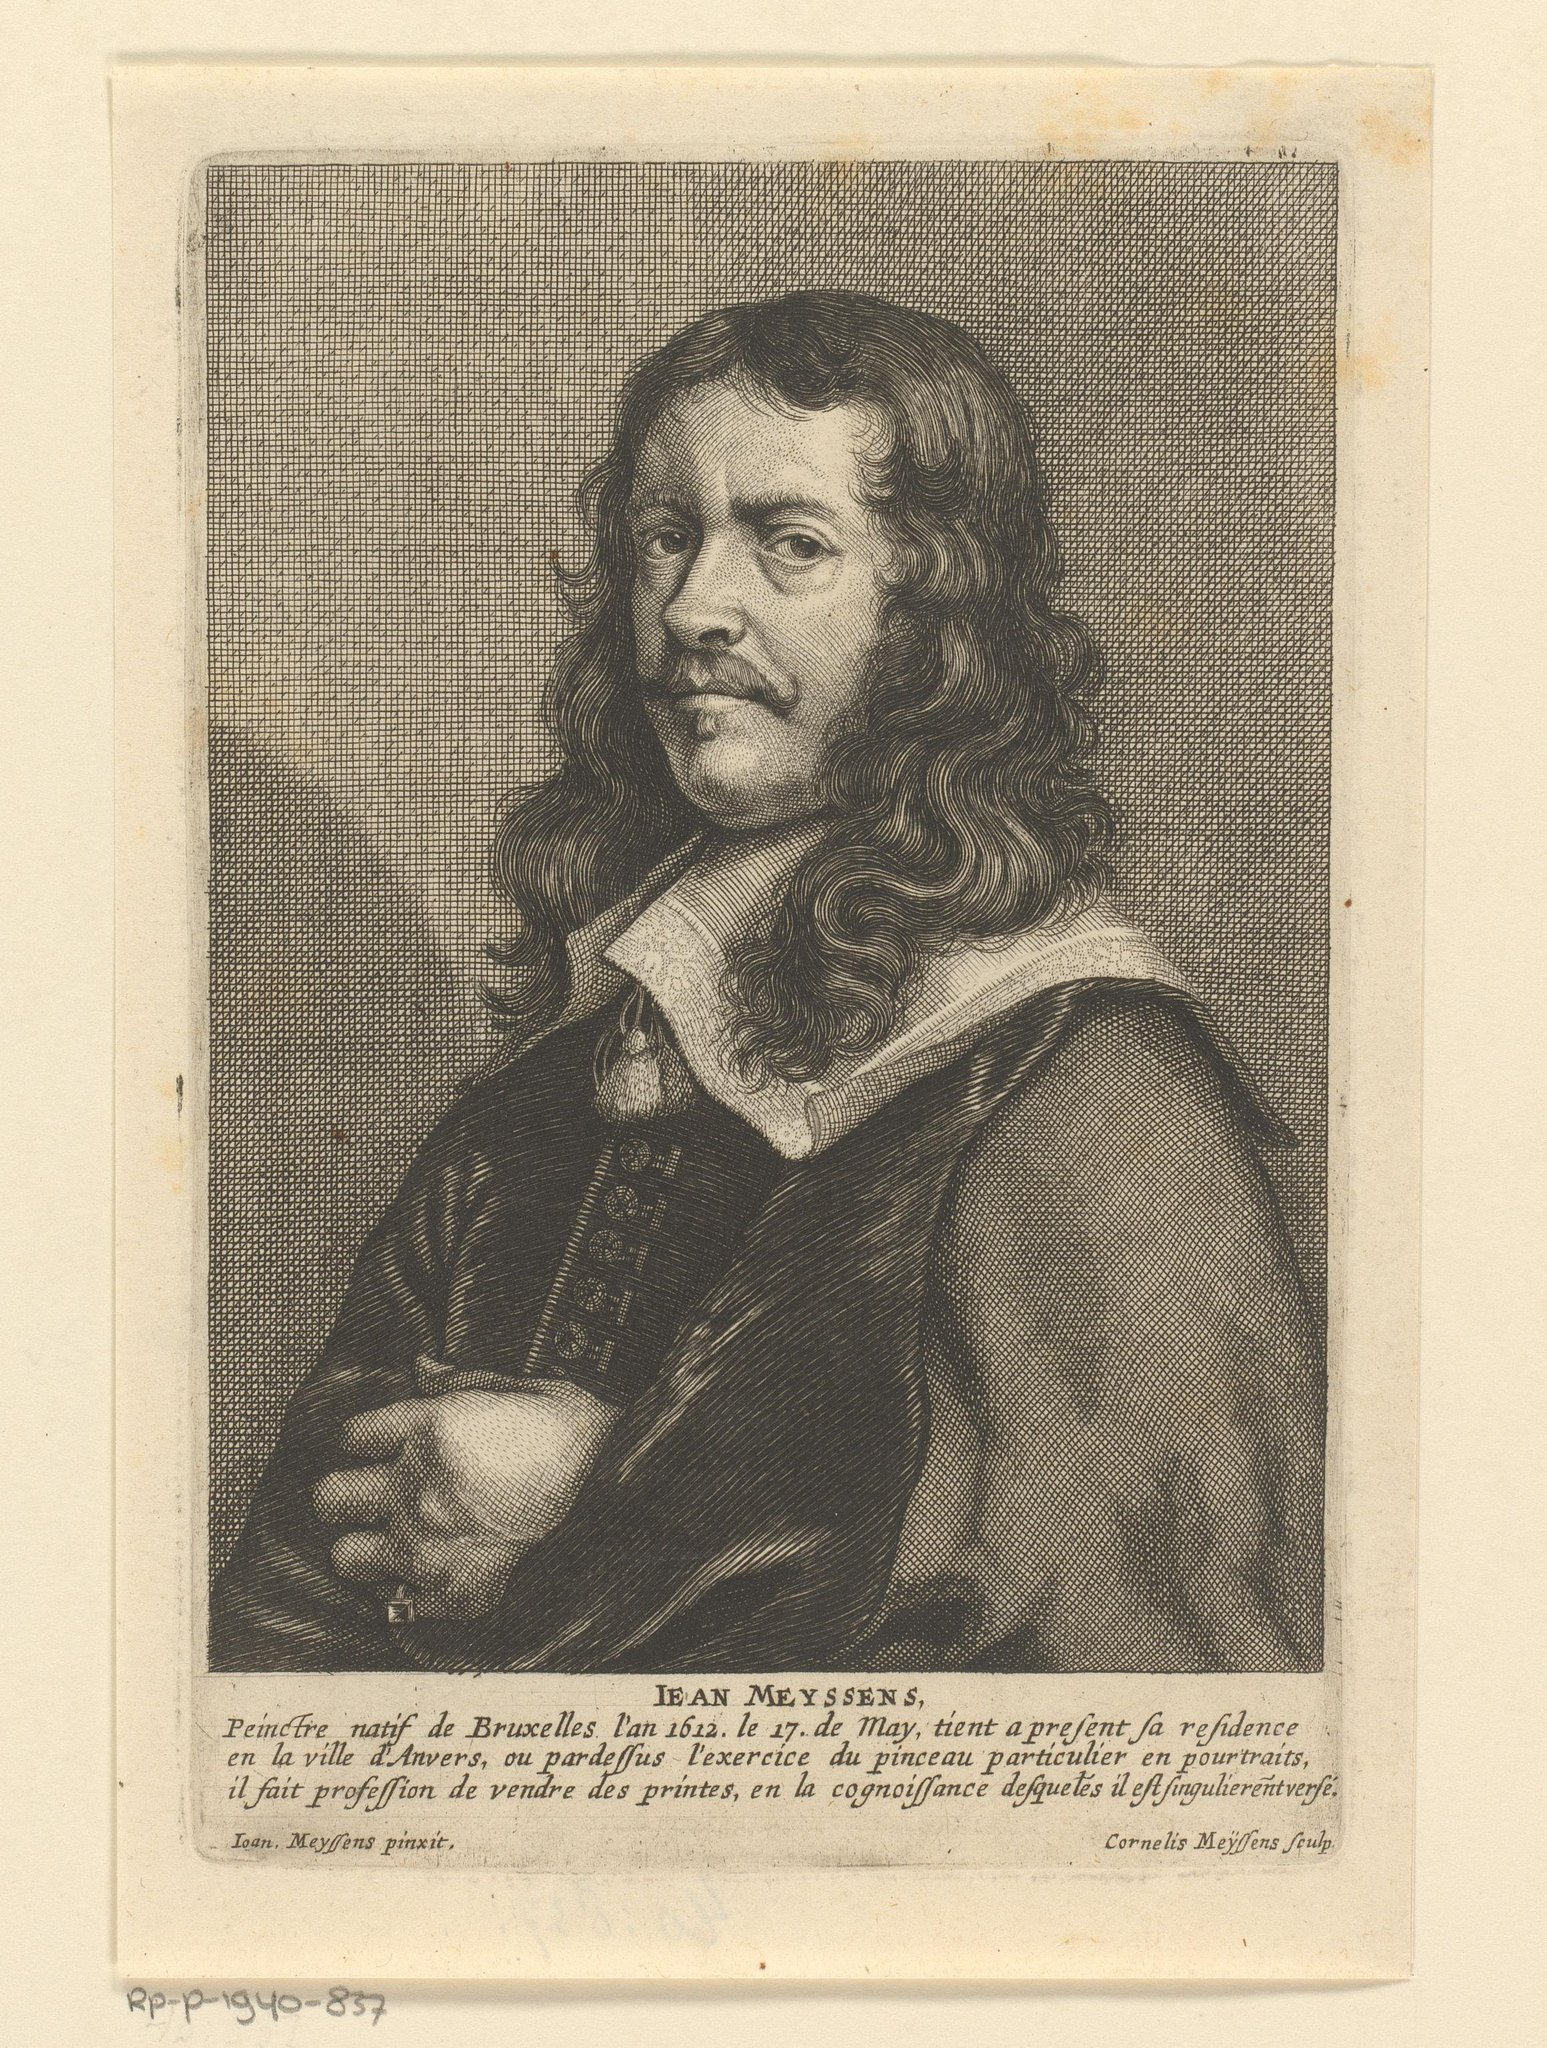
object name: print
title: Portret van Joannes Meyssens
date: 1660-1670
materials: paper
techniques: engraving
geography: antwerp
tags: brussels, antwerp, print maker, publisher, joannes meyssens, historical persons, portrait, self-portrait of artist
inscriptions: collector's mark: Lugt 2760, collector's mark: Lugt 2228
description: Andere prent met tekst in boekdruk op verso uit: Bie, Cornelis de. Het gulden cabinet vande edele vry schilder-const. Antwerpen: Joannes Meyssens en Juliaen van Montfort, 1662, dl. 2.